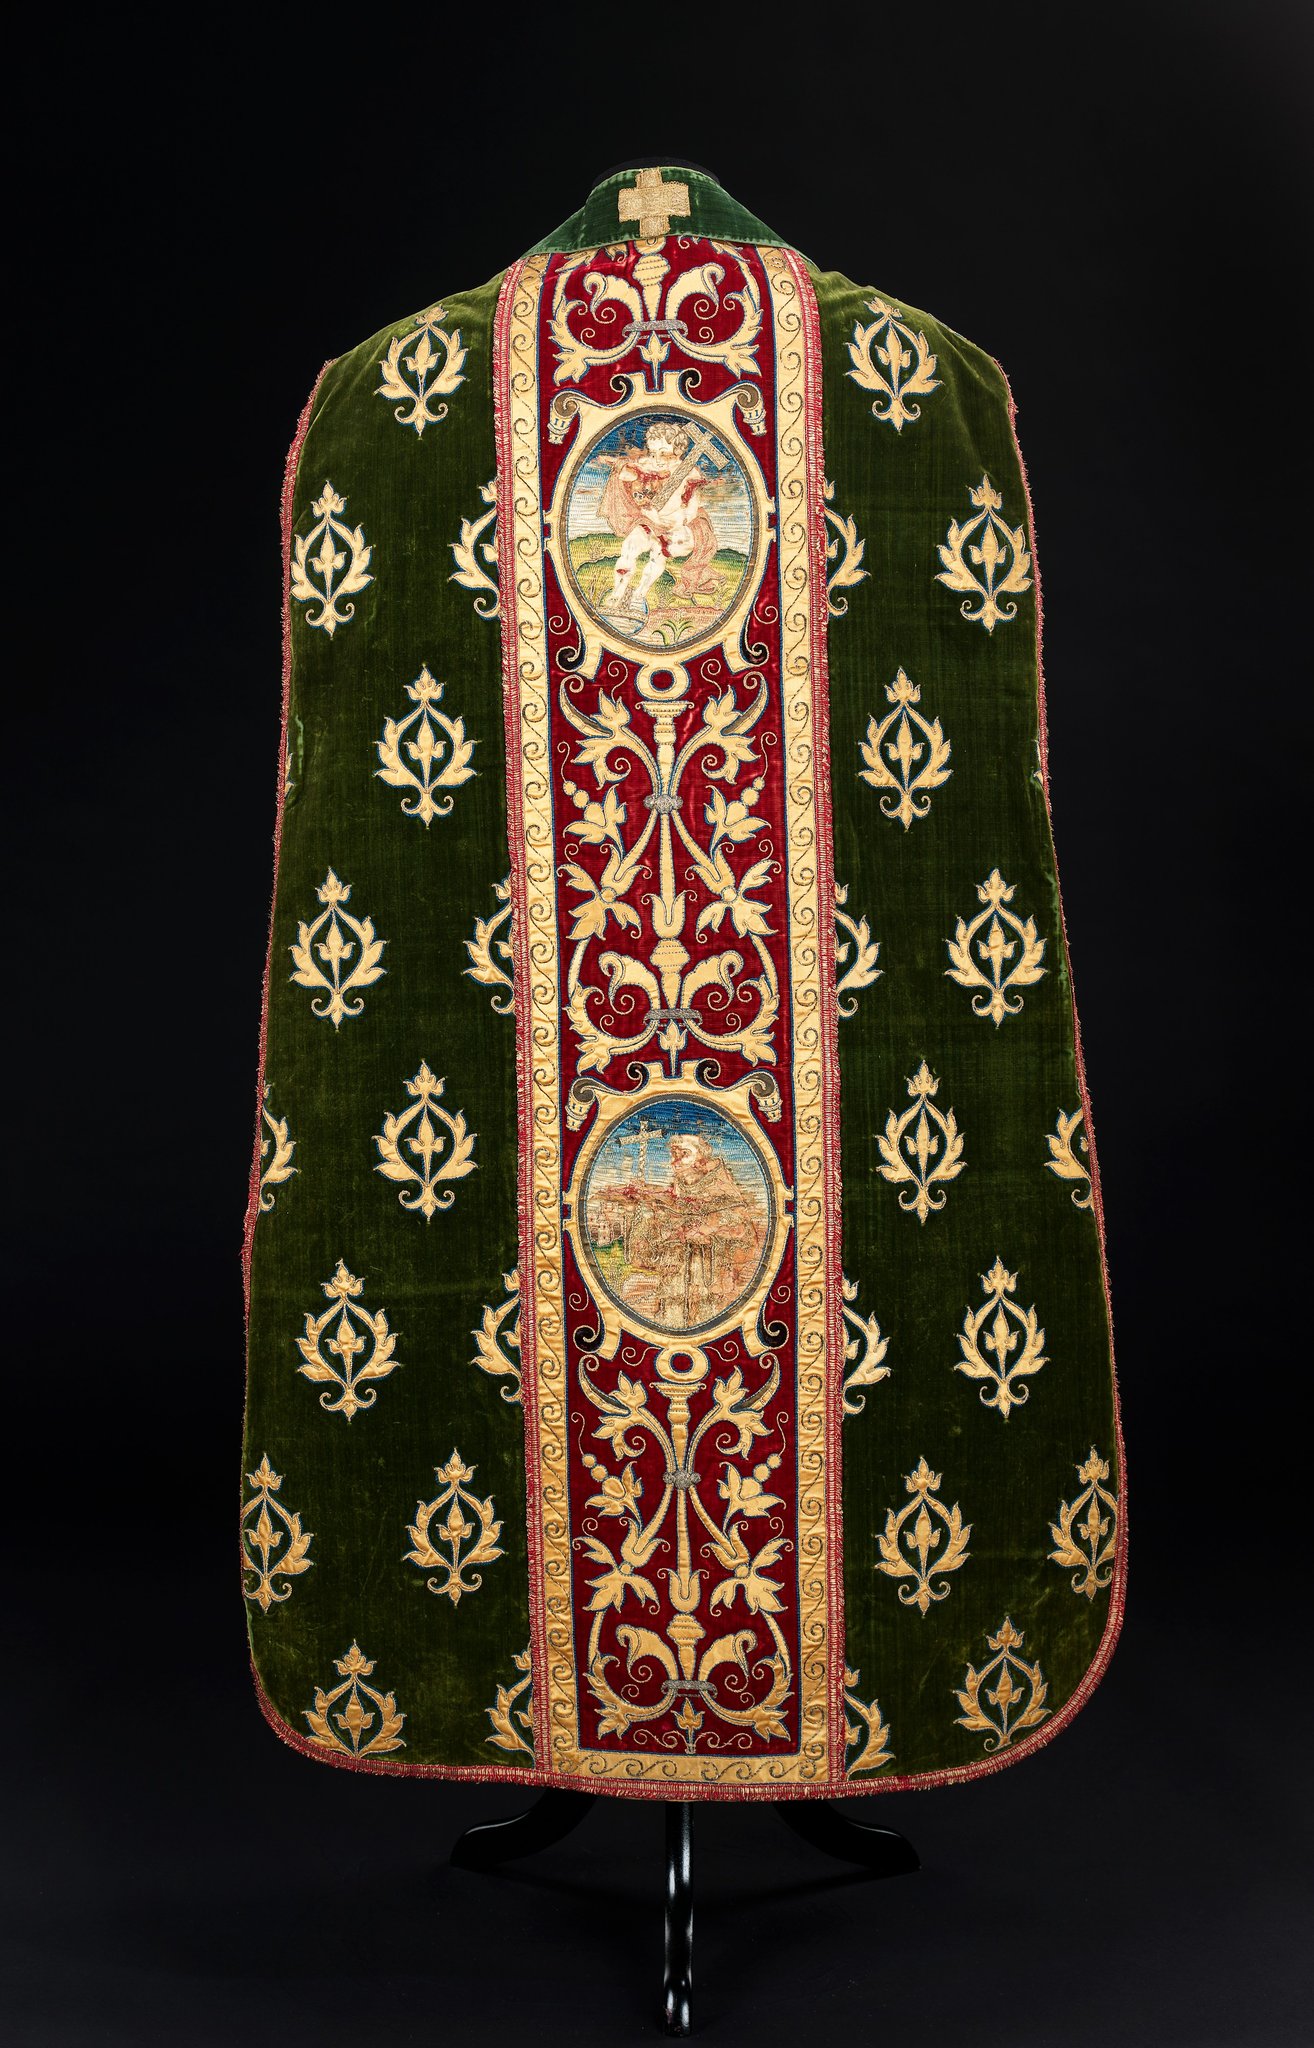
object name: vestment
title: Chasuble, stole and maniple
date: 1501-1600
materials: metal, silk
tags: cross